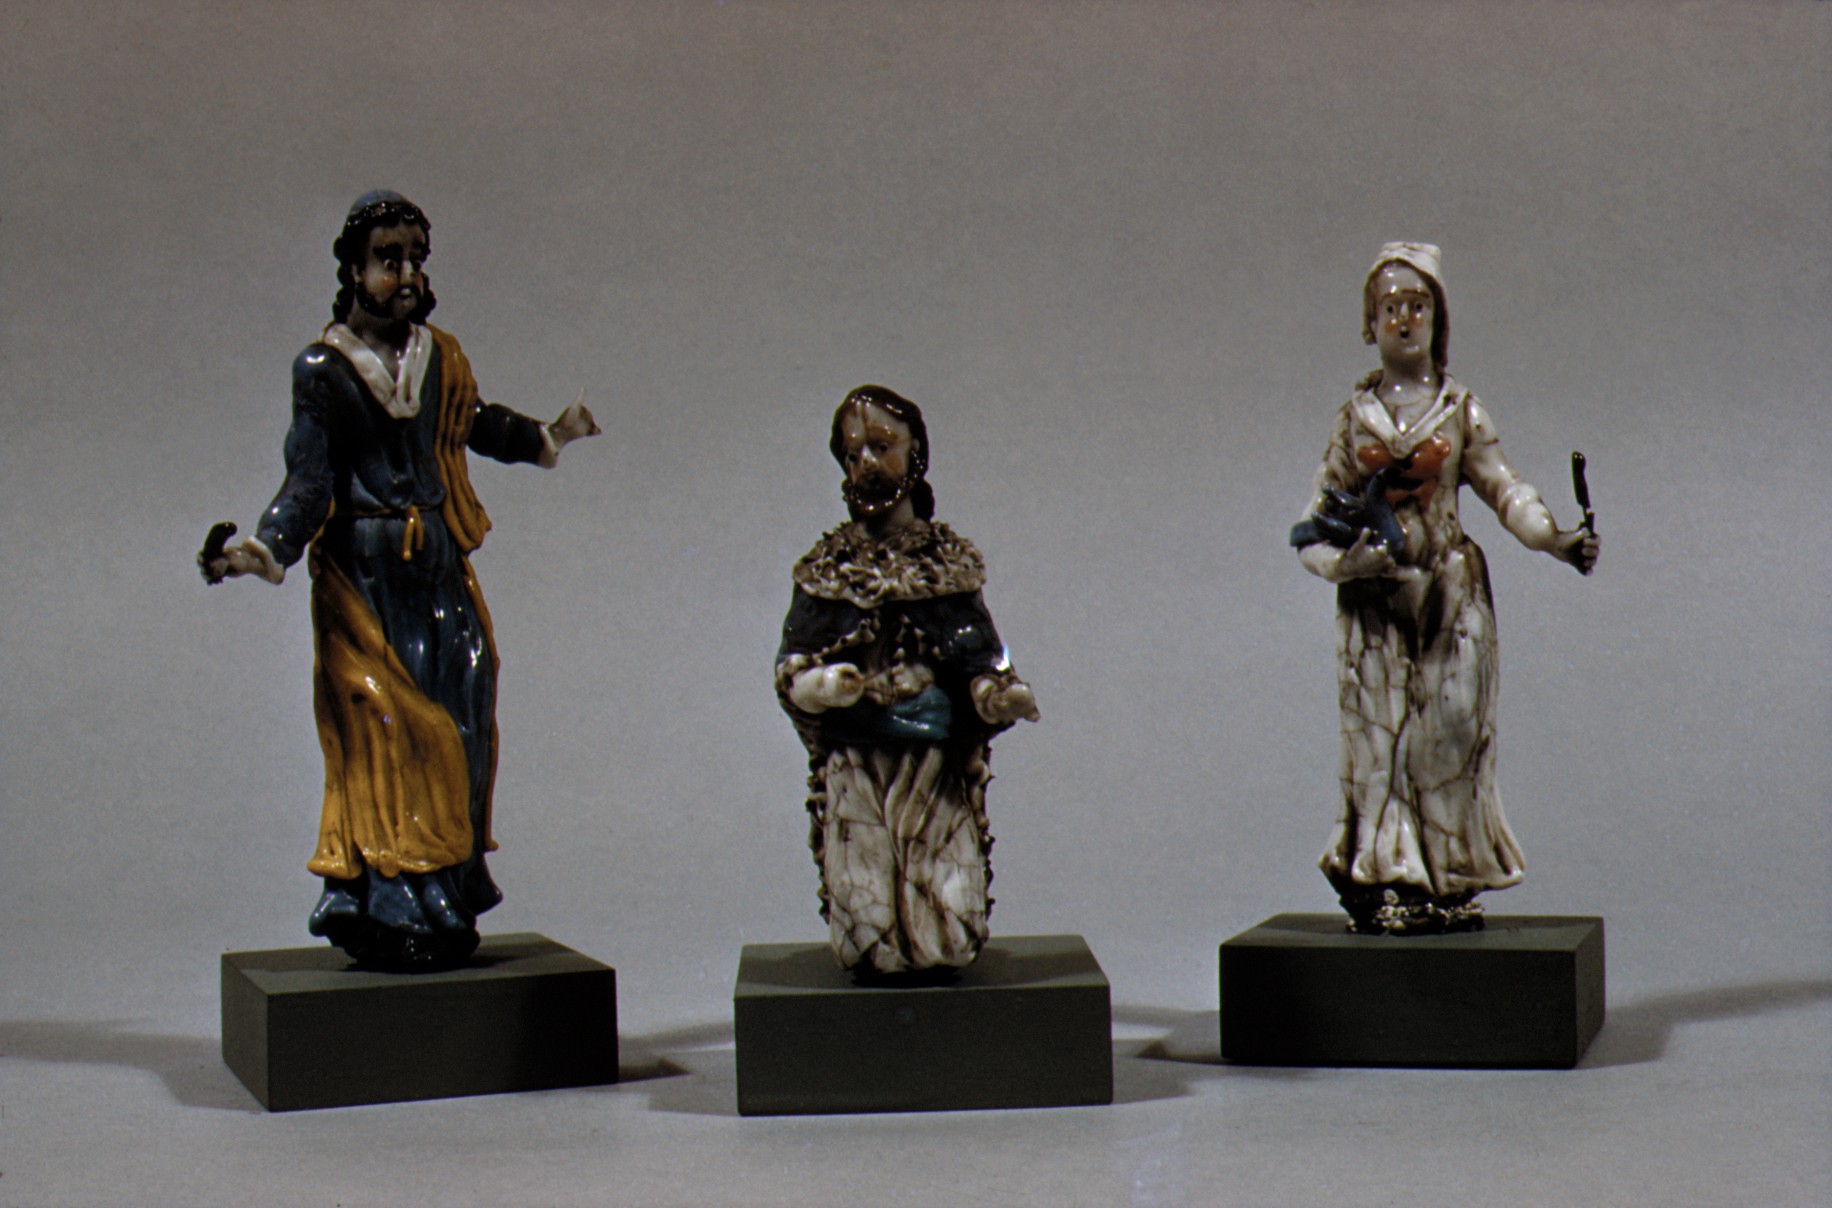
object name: statuette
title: Female statuette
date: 1701-1800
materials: glass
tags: women